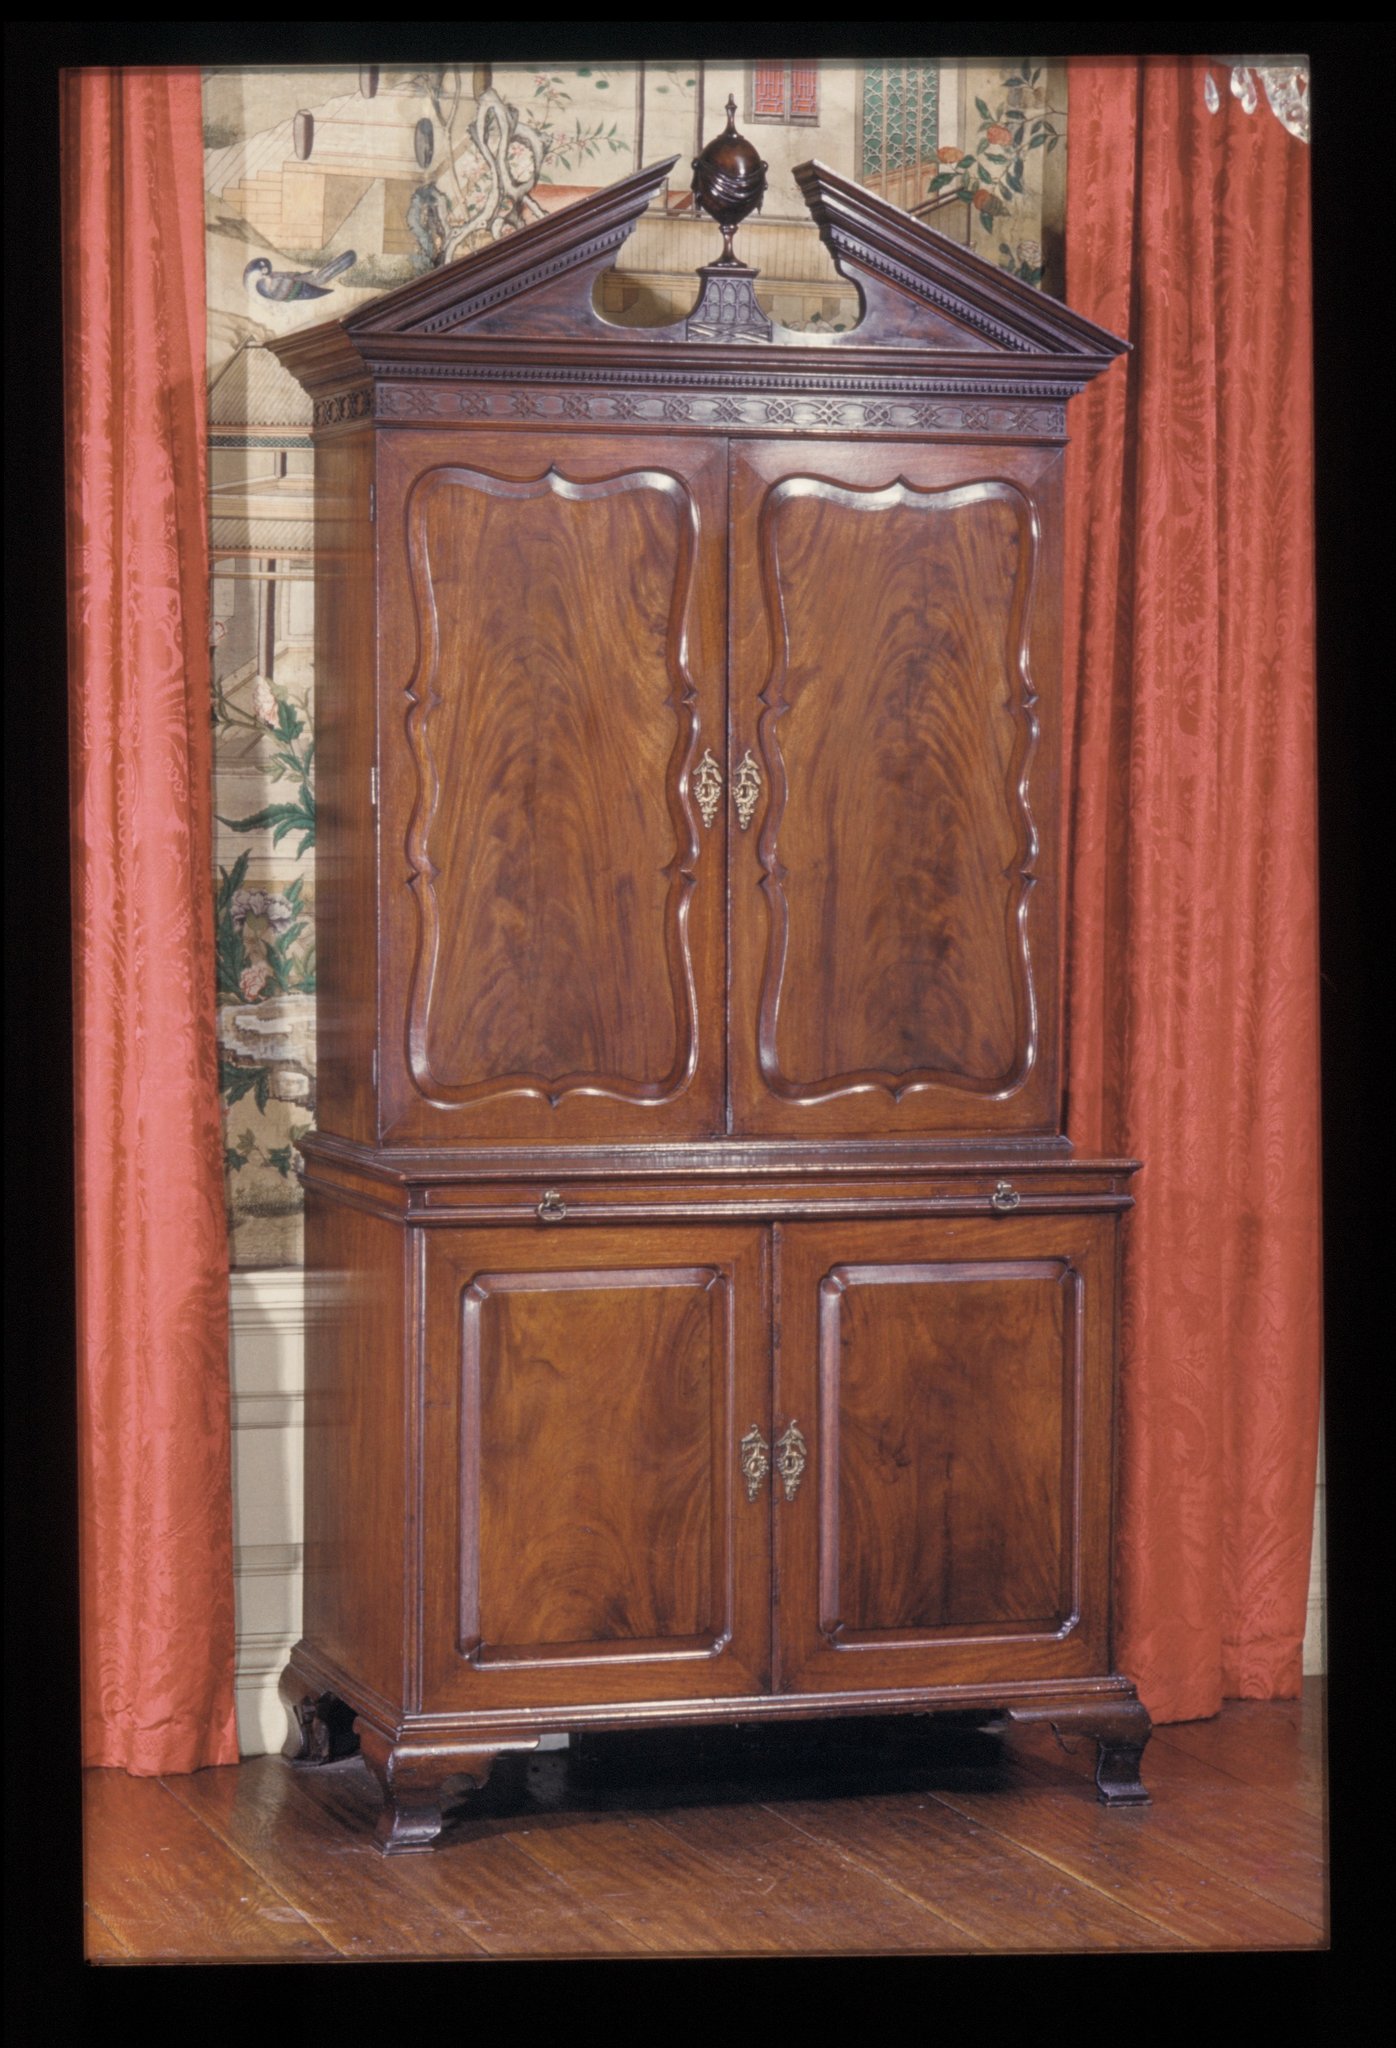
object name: clothes press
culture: american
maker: thomas affleck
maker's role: maker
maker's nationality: american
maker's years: 1740-1795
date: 1760-1790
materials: wood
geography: united states